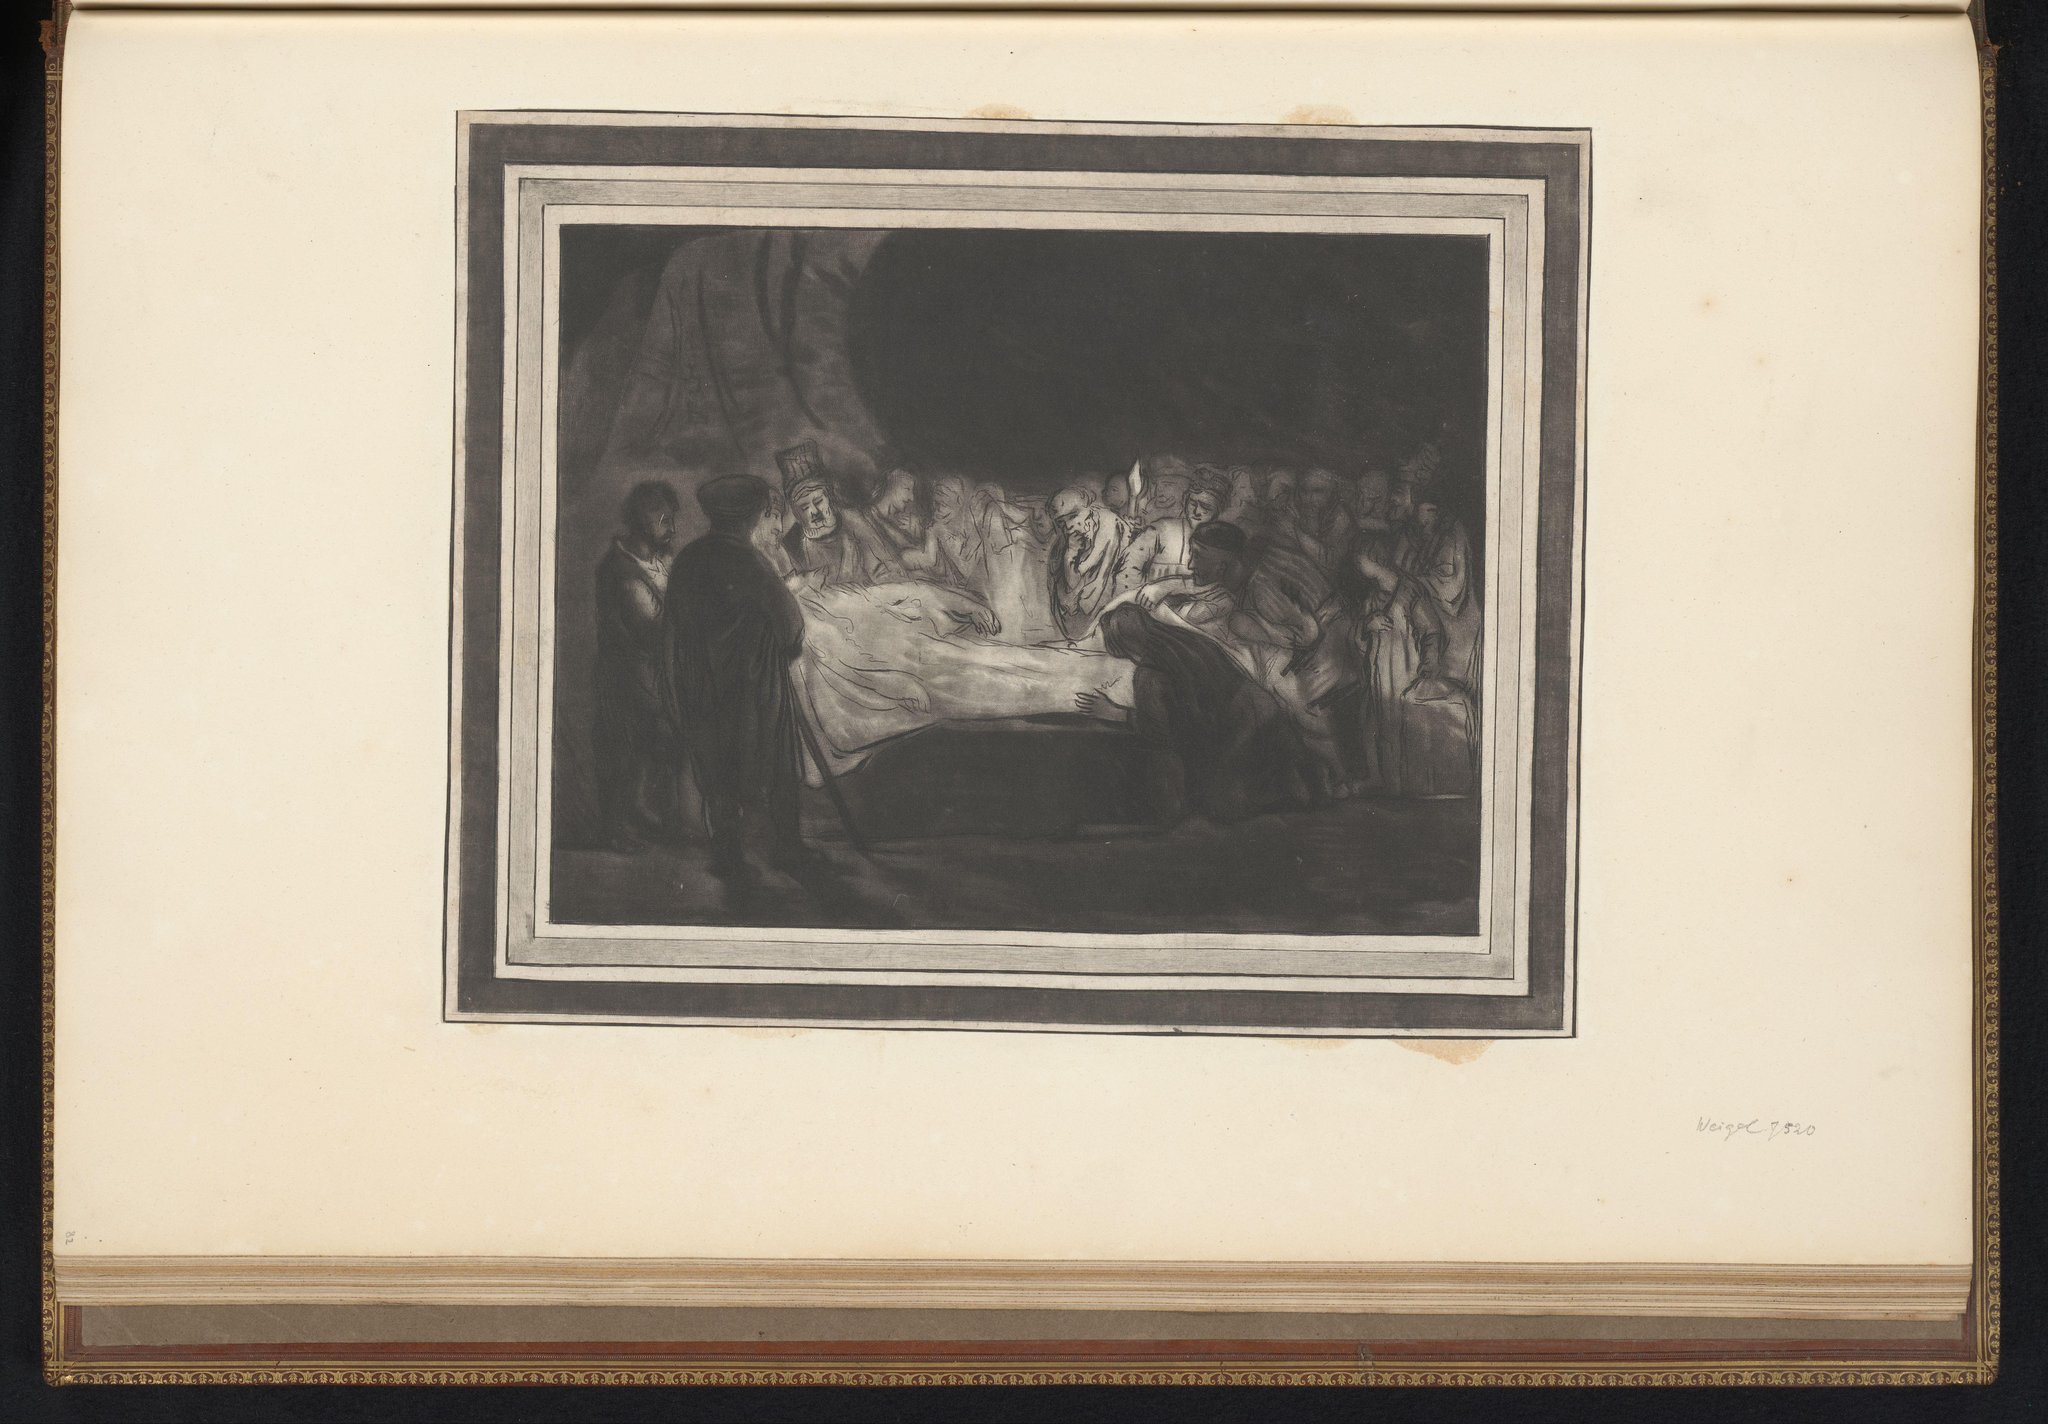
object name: print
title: Graflegging van Christus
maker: william baillie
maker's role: print maker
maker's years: 1723-1810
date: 1753-1810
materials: paper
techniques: etching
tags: christ's entombment (possibly by angels)